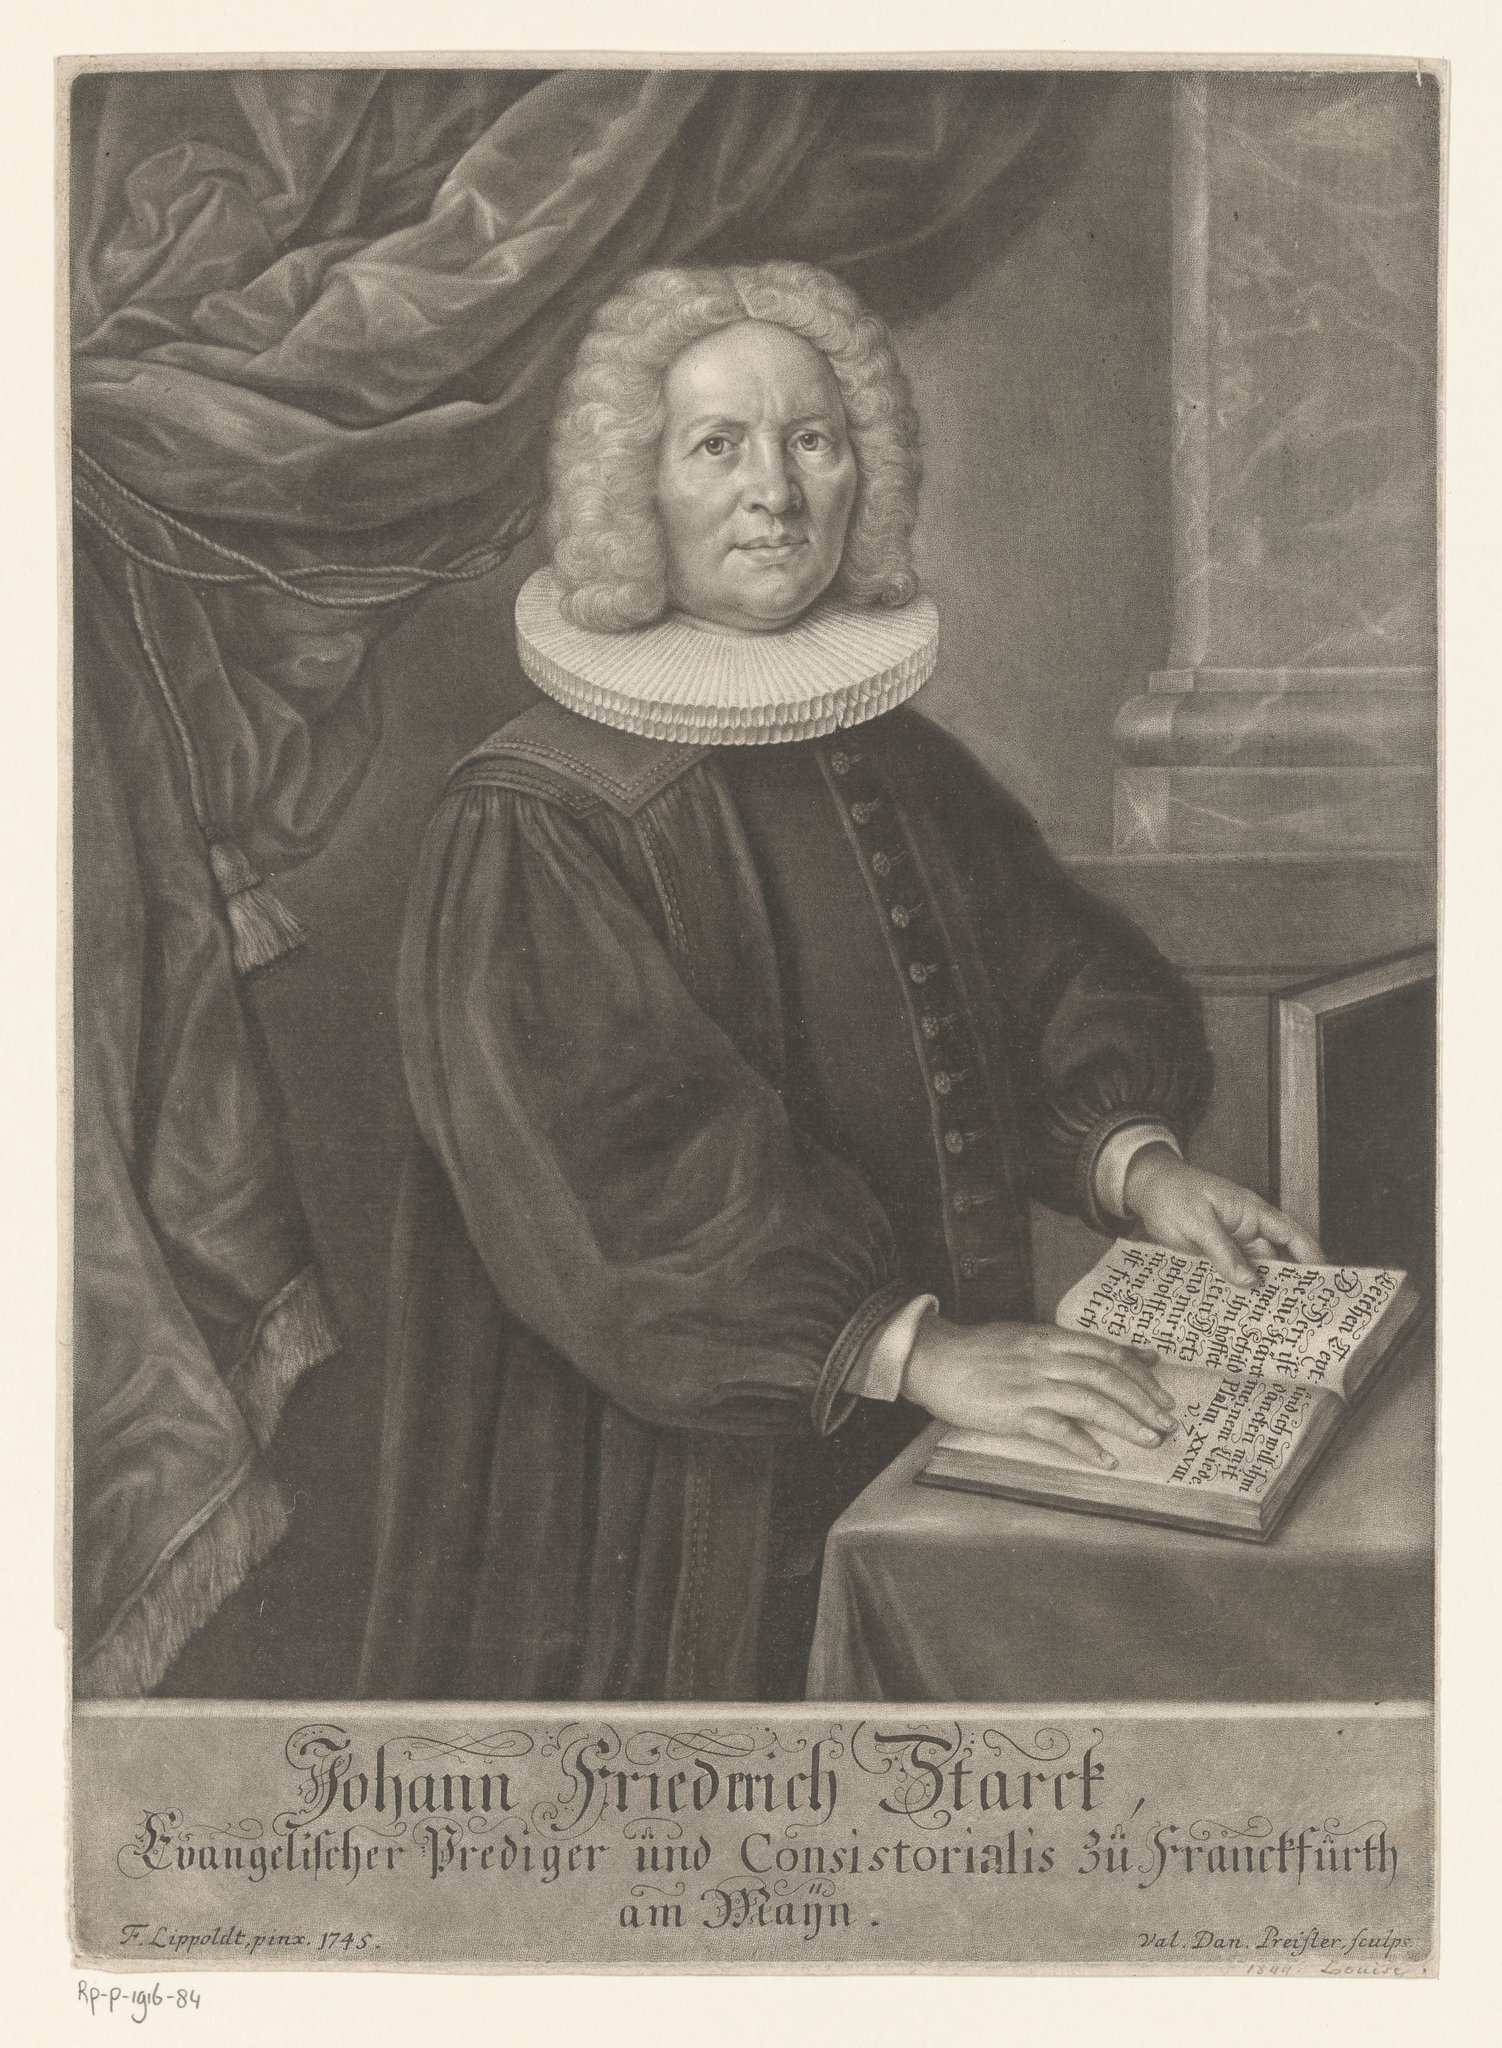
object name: print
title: Portret van Johann Friedrich Starck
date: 1745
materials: paper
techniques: mezzotint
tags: theologian, historical persons, book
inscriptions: collector's mark: Lugt 2228